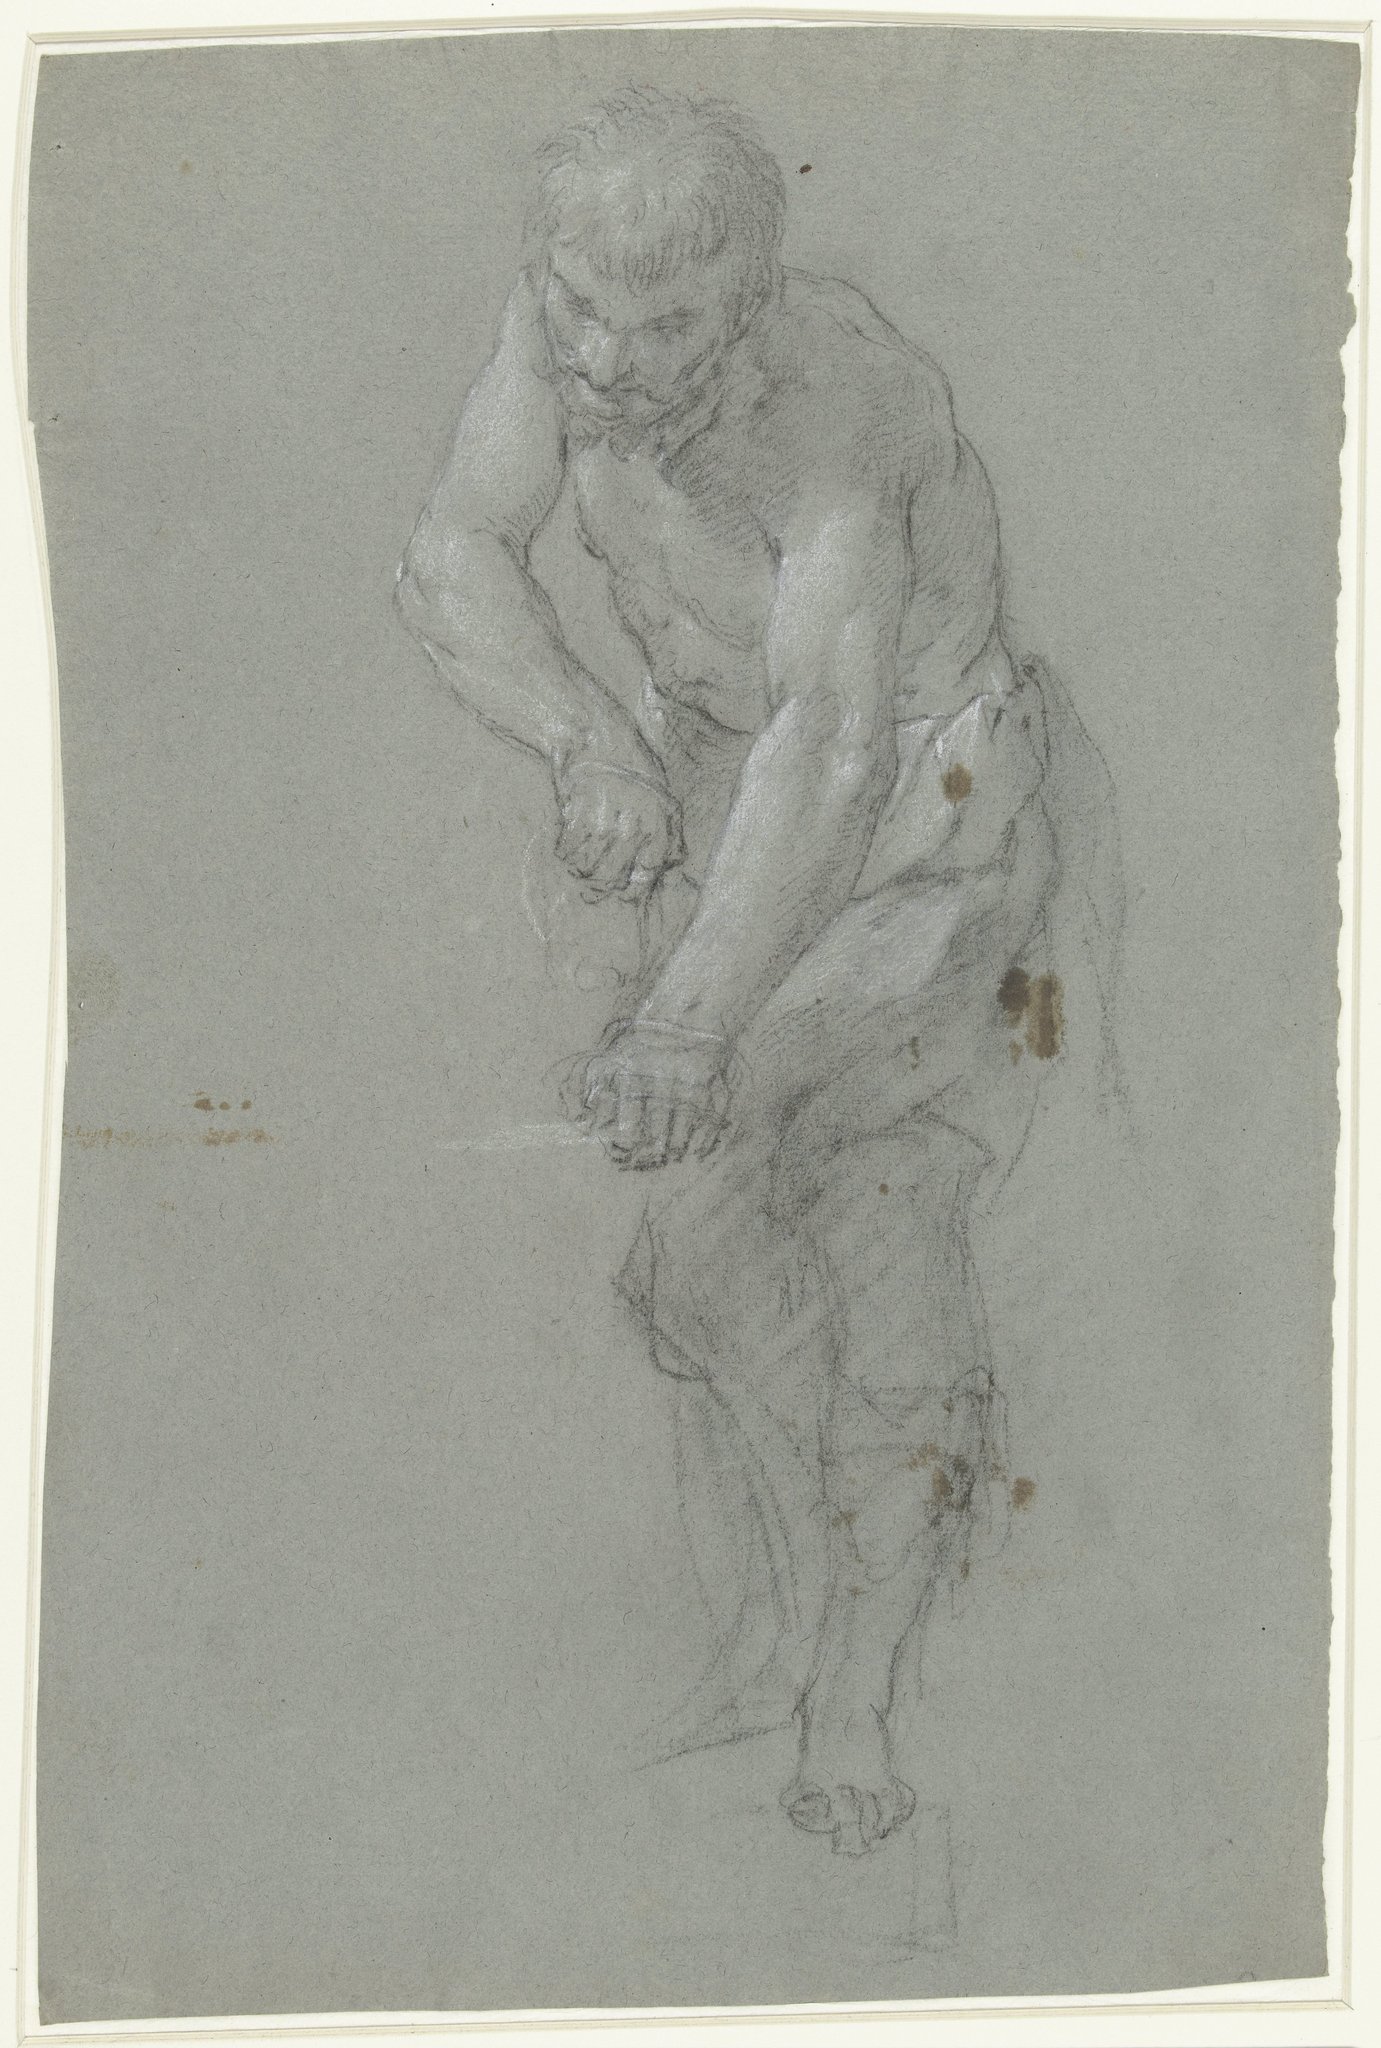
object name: drawing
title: Een schavende man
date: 1600-1699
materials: chalk, paper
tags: handicrafts ~ wood, timber